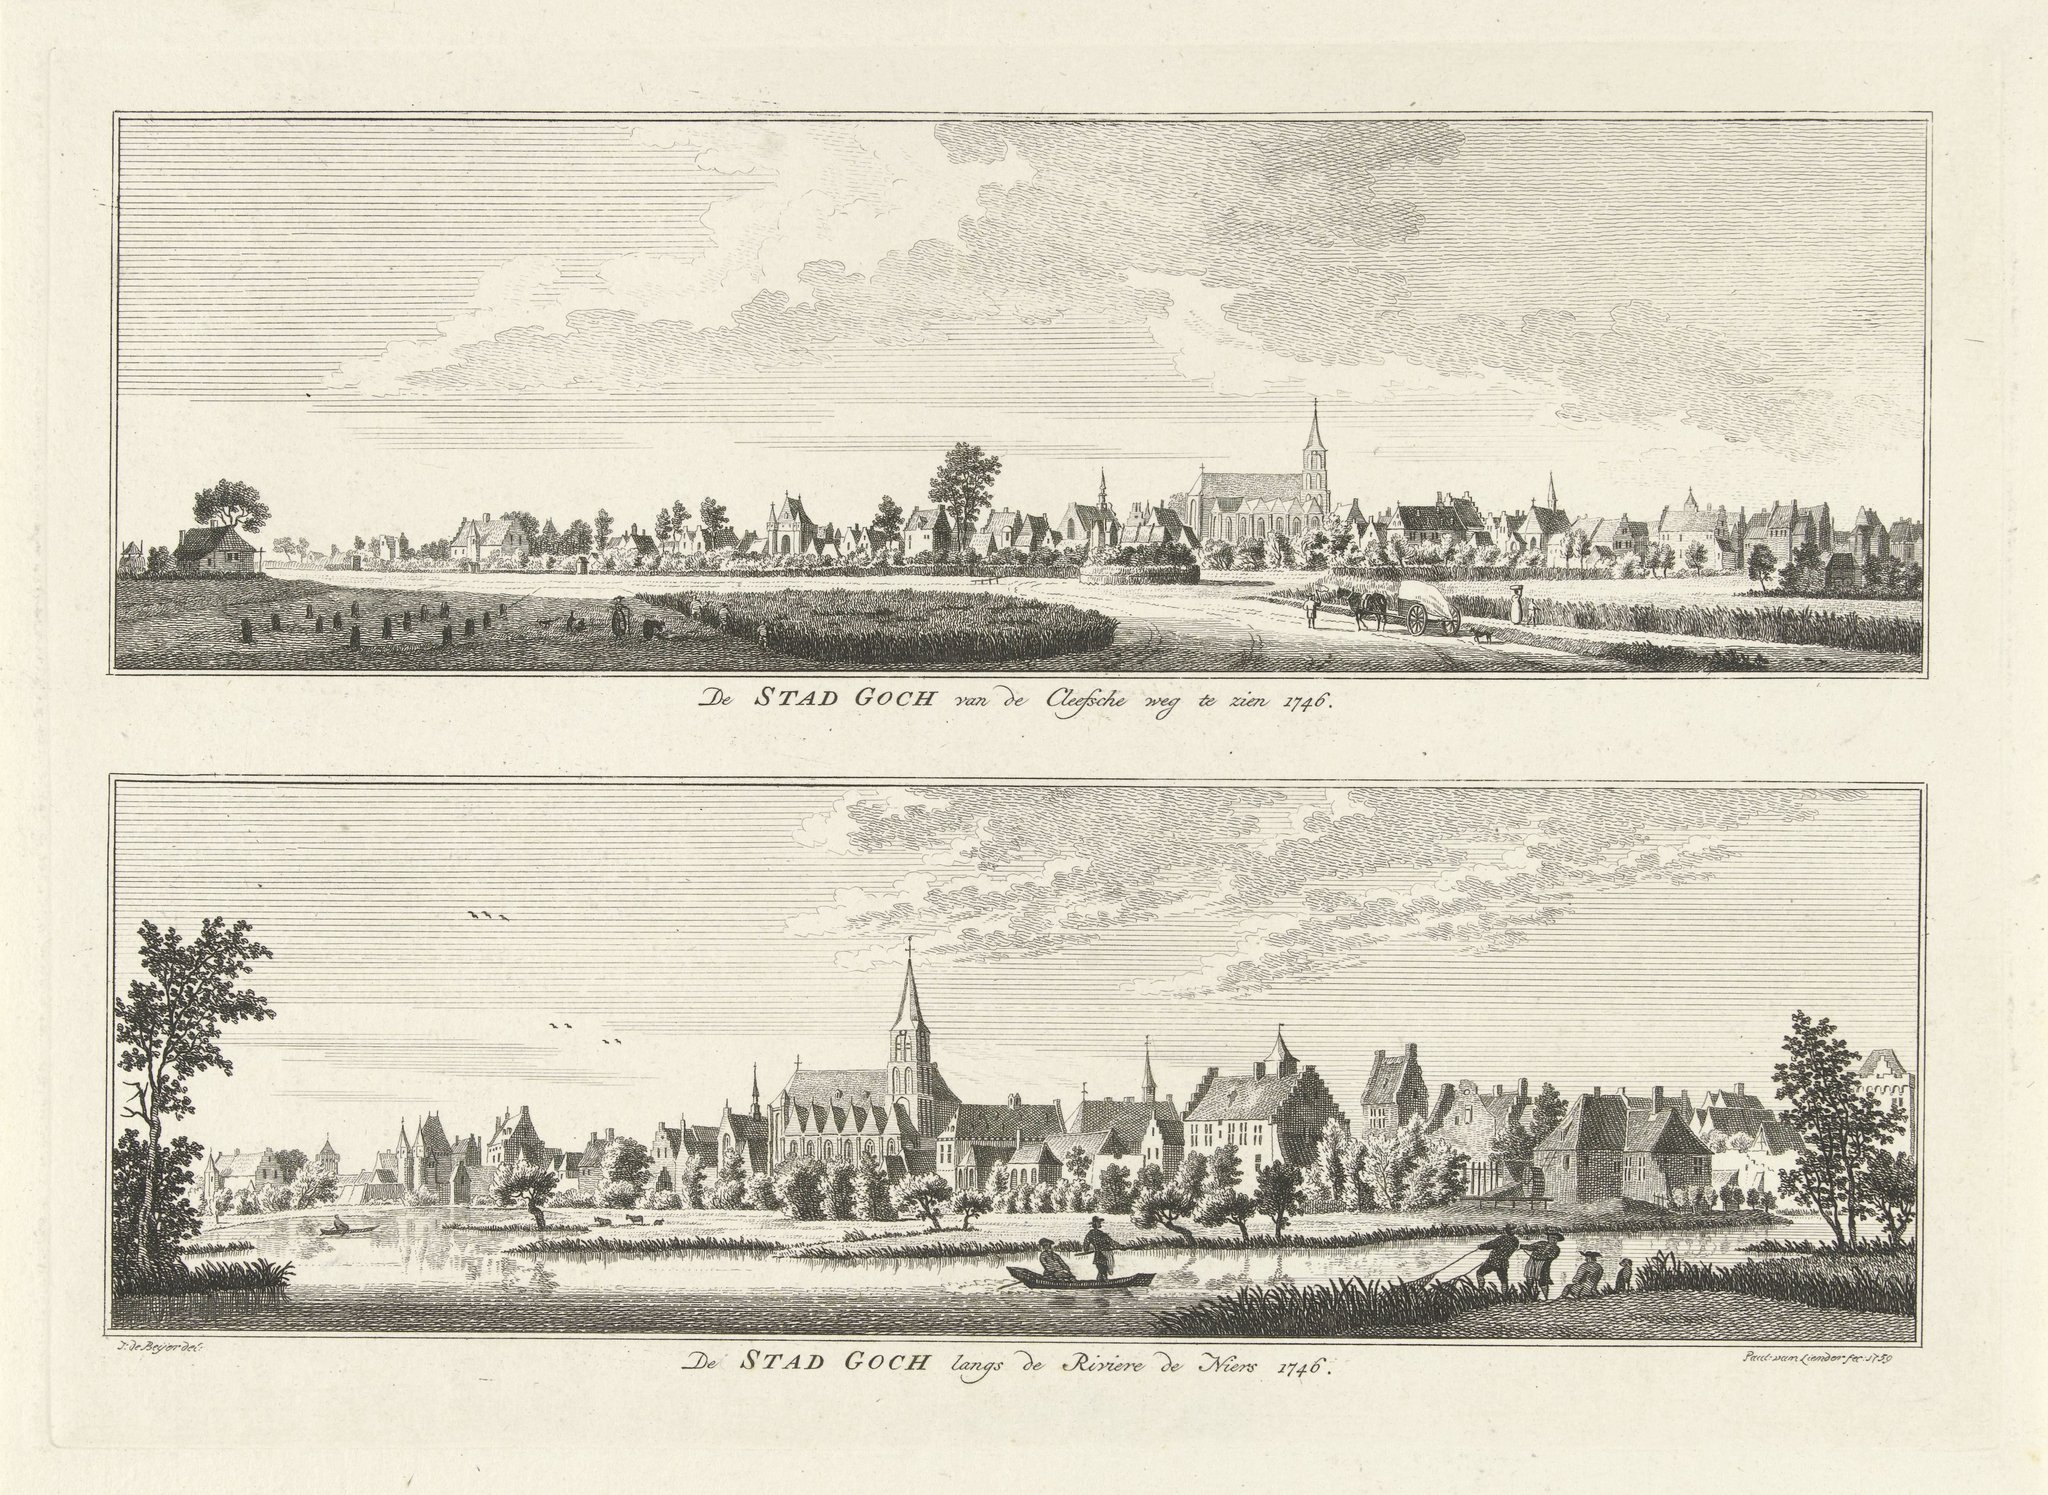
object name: print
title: Stadsgezichten te Goch, 1746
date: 1759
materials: paper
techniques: etching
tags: city-view in general; 'veduta', landscapes with waters, waterscapes, seascapes (in the temperate zone), cultivated land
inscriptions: collector's mark: Lugt 240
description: Twee gezichten op de Duitse stad Goch. Op de voorgrond akkers (boven) en rivier de Niers (onder). Twee voorstellingen van één plaat.